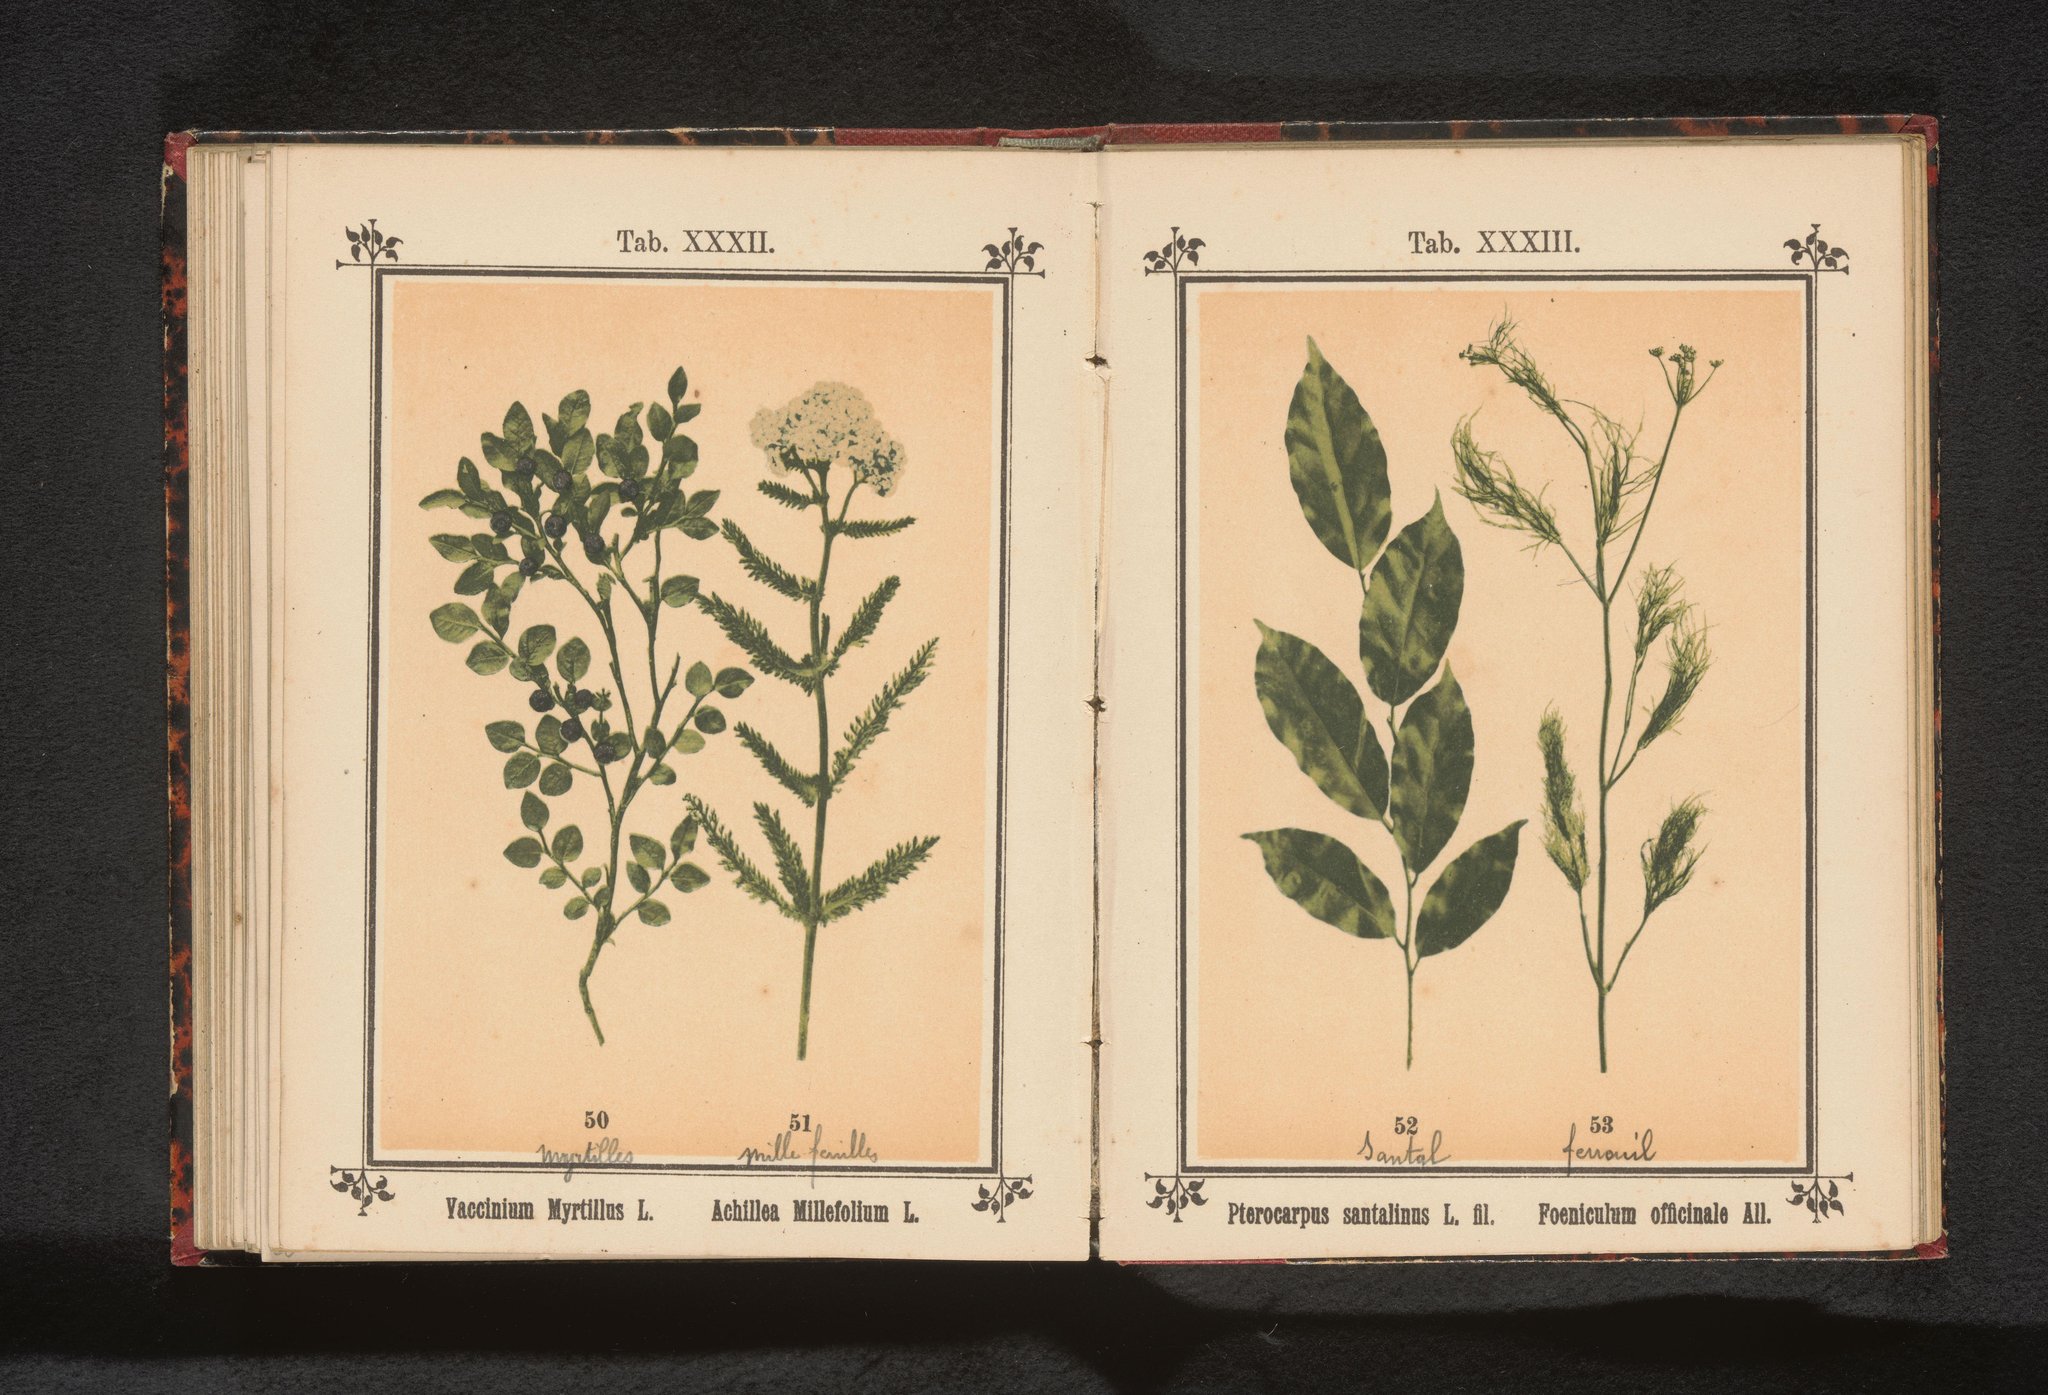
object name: photomechanical print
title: Pterocarpus santalinus L. fil. Foeniculum officinale Al..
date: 1884-1894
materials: paper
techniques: photograph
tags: plants (in general) (+ branch, stick)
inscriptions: number: ‘Tab. XXXIII.’, inscription: ‘santal fennouil’